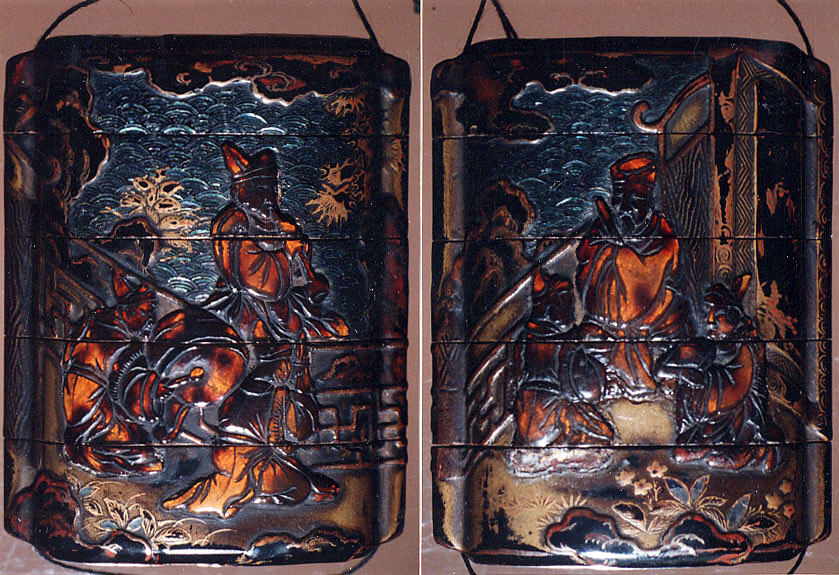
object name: inrō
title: Case (Inrō) with Design of Chinese Sages Playing Musical Instruments on a Verandah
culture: japanese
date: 1601-1800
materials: lacquer, shell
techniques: fundame, hiramakie, roiro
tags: musical instruments,men,flowers